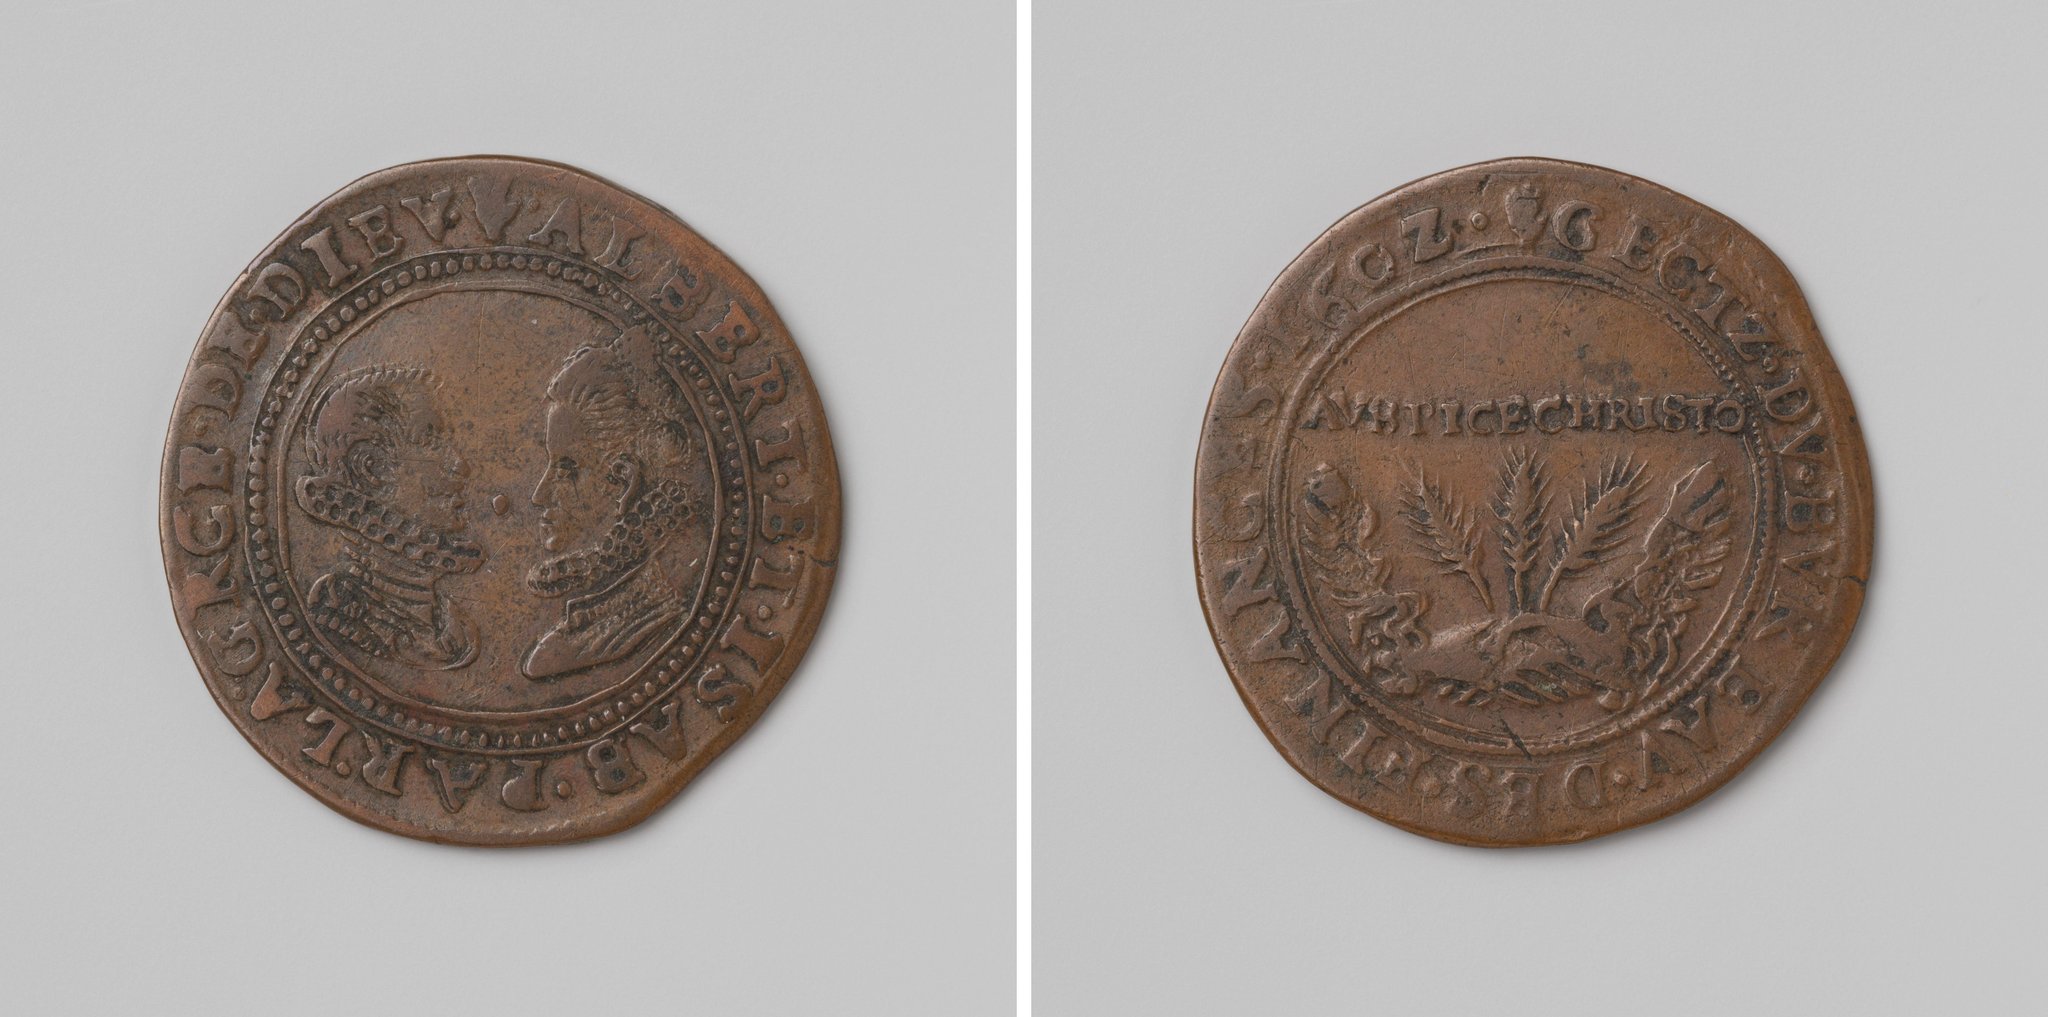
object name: jeton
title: Albrecht en Isabella van Oostenrijk, rekenpenning van de raad van Financiën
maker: Anonymous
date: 1602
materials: copper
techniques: striking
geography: antwerp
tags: infante van spanje isabella clara eugenia, brussels, albrecht aartshertog van oostenrijk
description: Koperen penning. Voorzijde: naar elkaar gewende borststukken van man en vrouw binnen omschrift. Keerzijde: twee ineen geslagen handen met vleugels houden gezamenlijk drie korenaren vast onder opschrift binnen omschrift